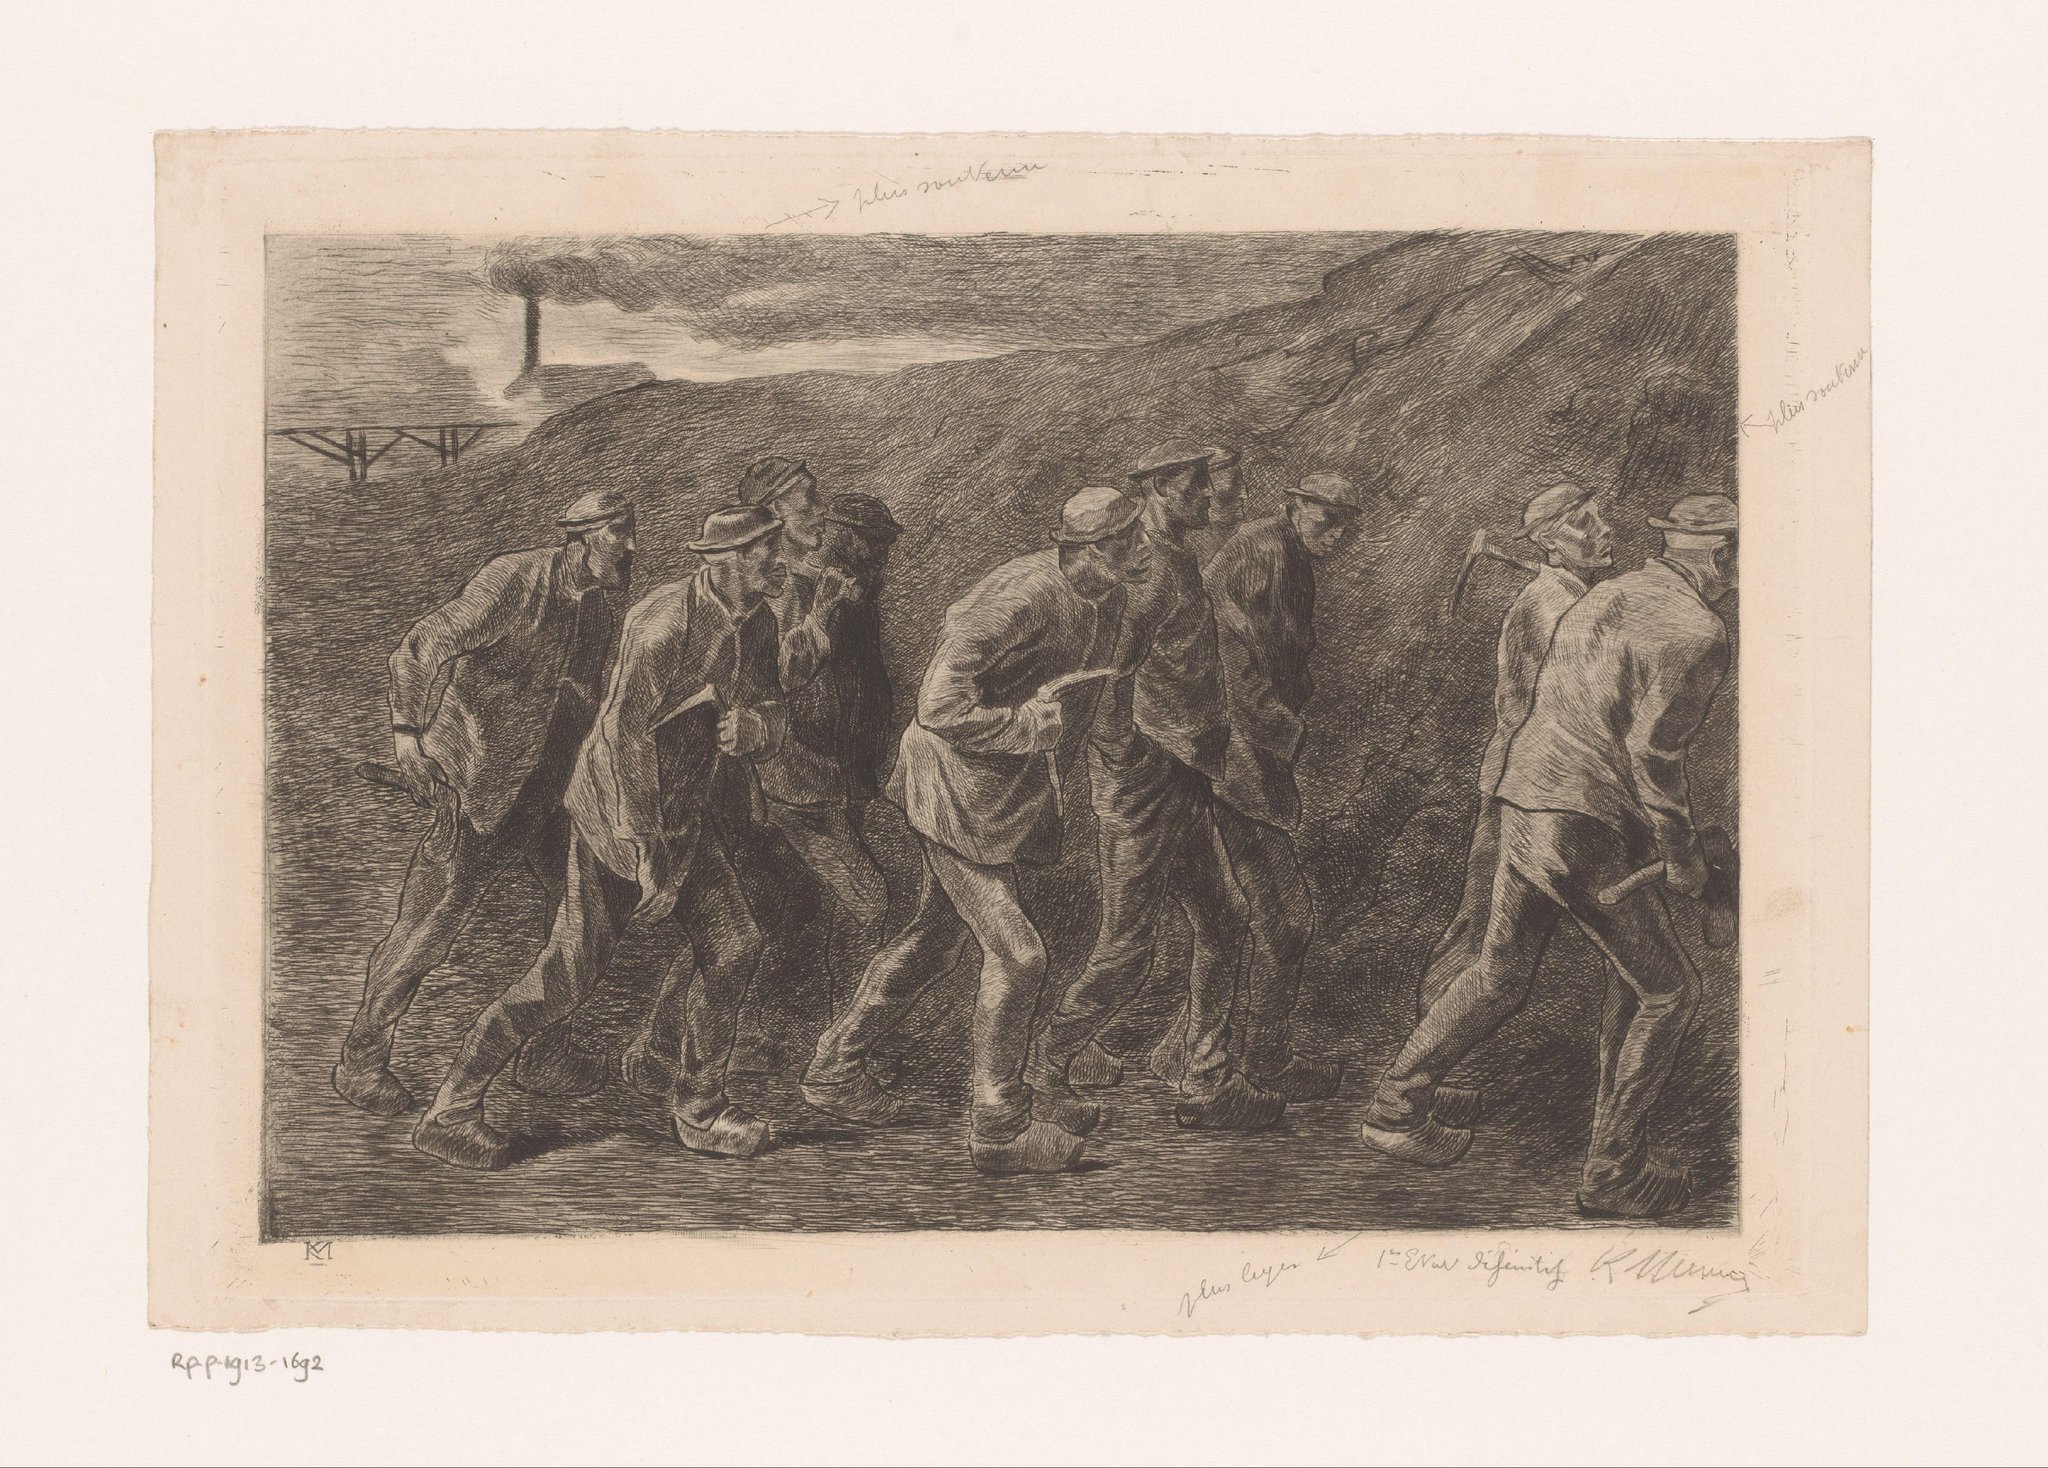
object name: print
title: Tien mijnwerkers op weg naar hun werk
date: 1874-1894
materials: paper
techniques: etching, intaglio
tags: miner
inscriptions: inscription: ‘1er Etat difénitif’, inscription, collector's mark: Lugt 2228